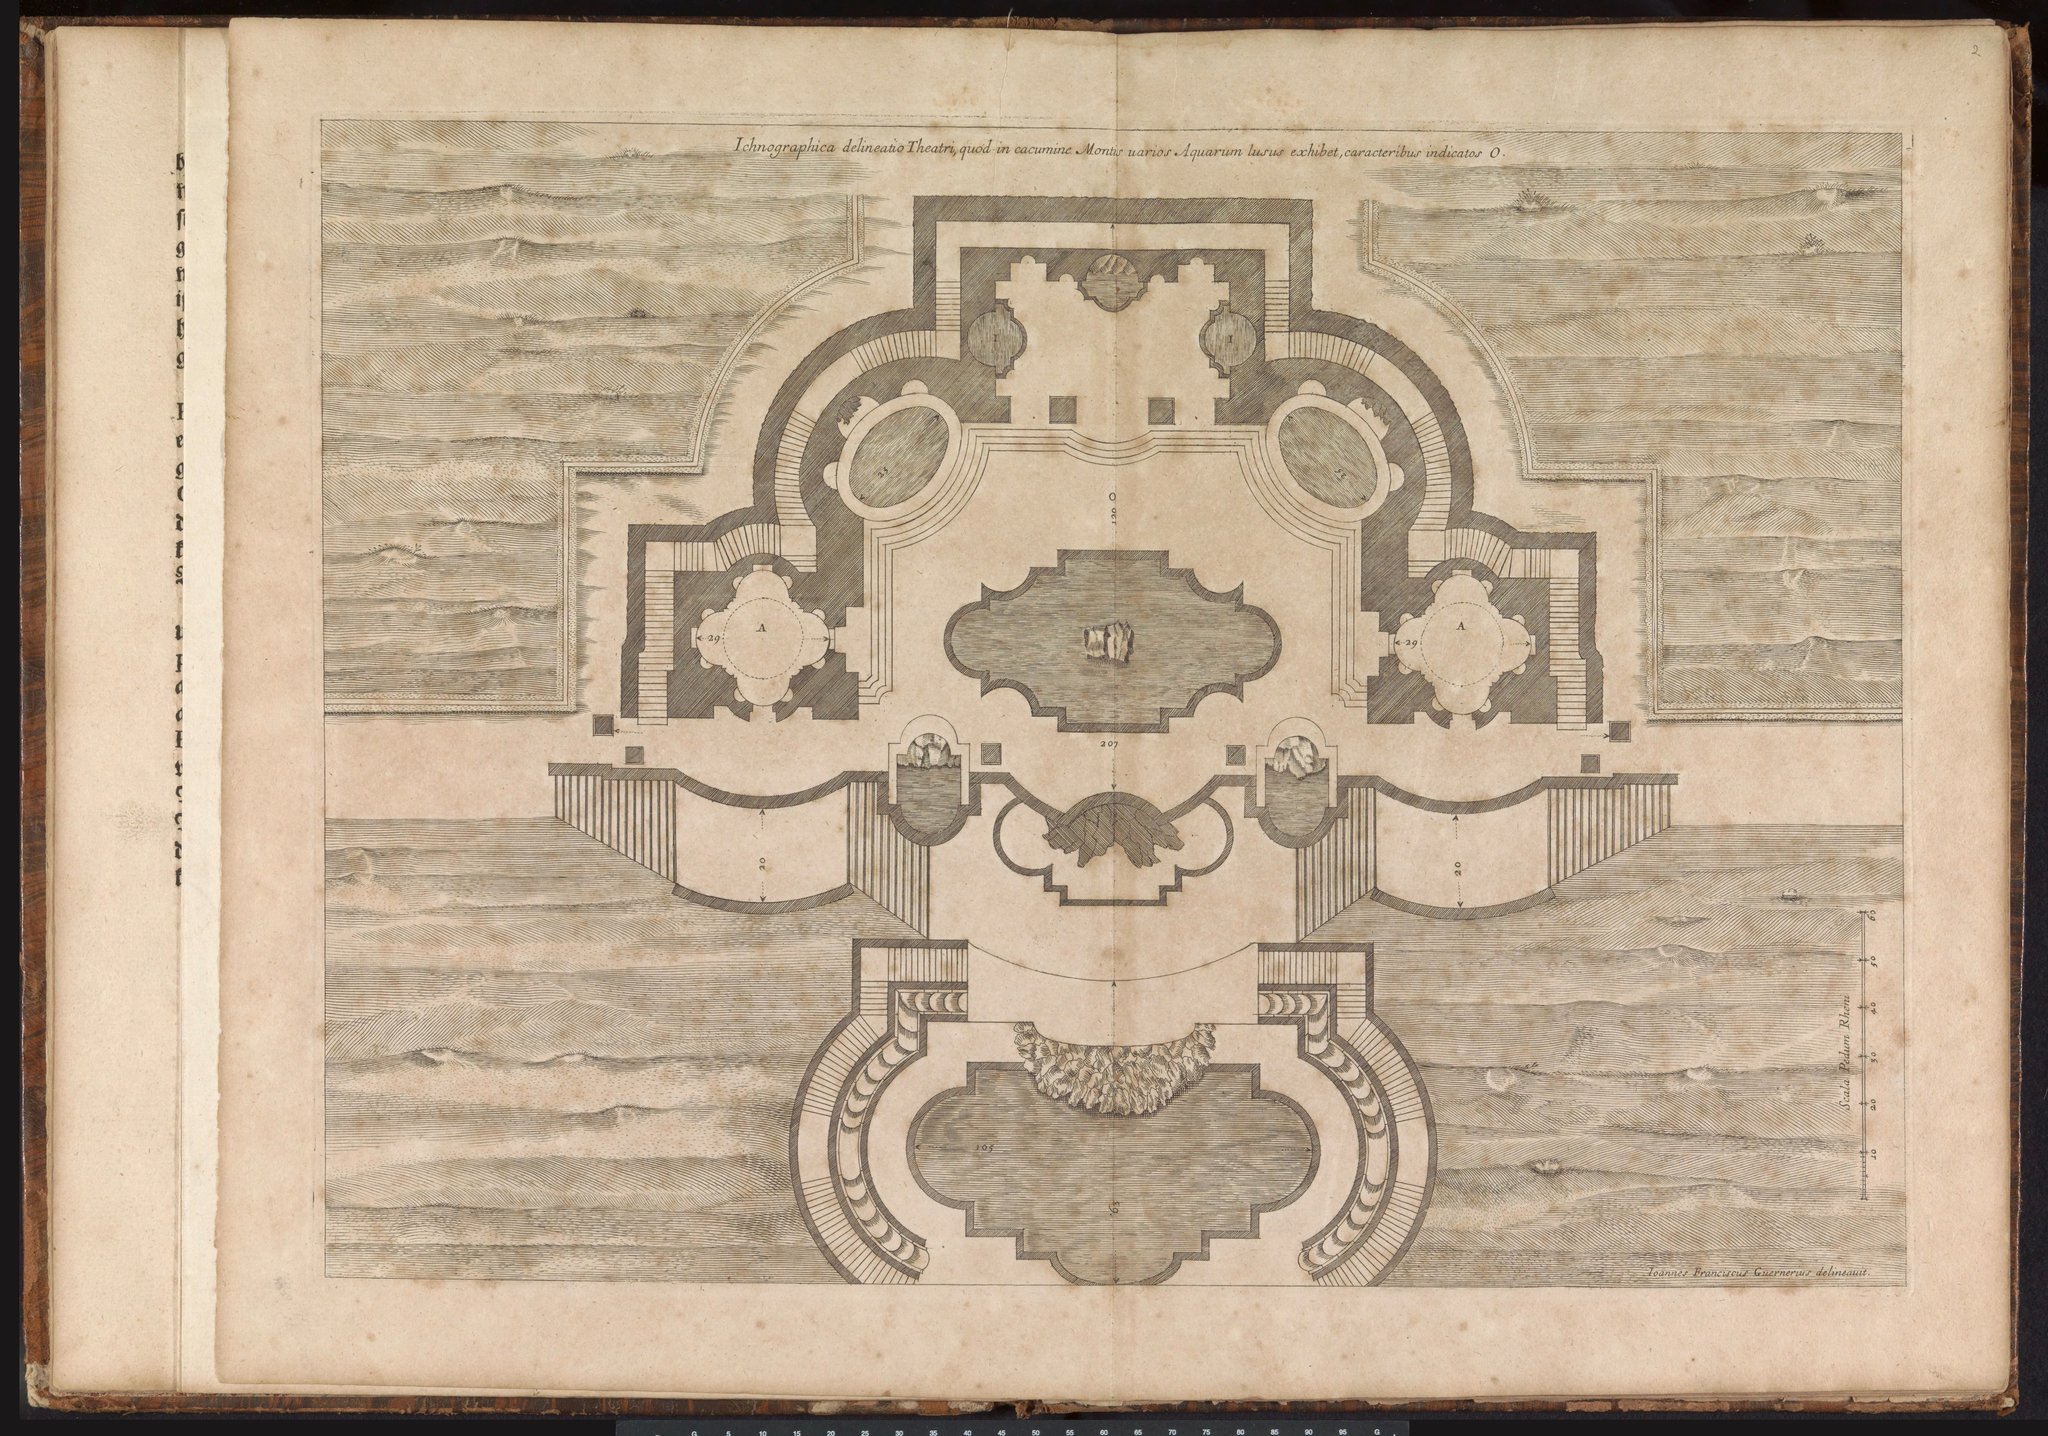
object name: album leaf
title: Disegno del monte situato presso la citta metropolitana di Cassel (...)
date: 1706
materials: paper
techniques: etching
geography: italy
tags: theatre (building) - aa - open-air performances